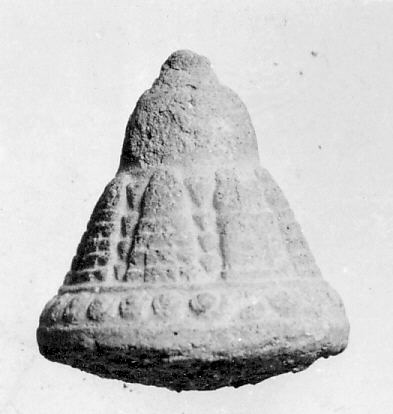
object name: plaque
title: Votive Plaque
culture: central asian or tibetan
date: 1101-1900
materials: clay